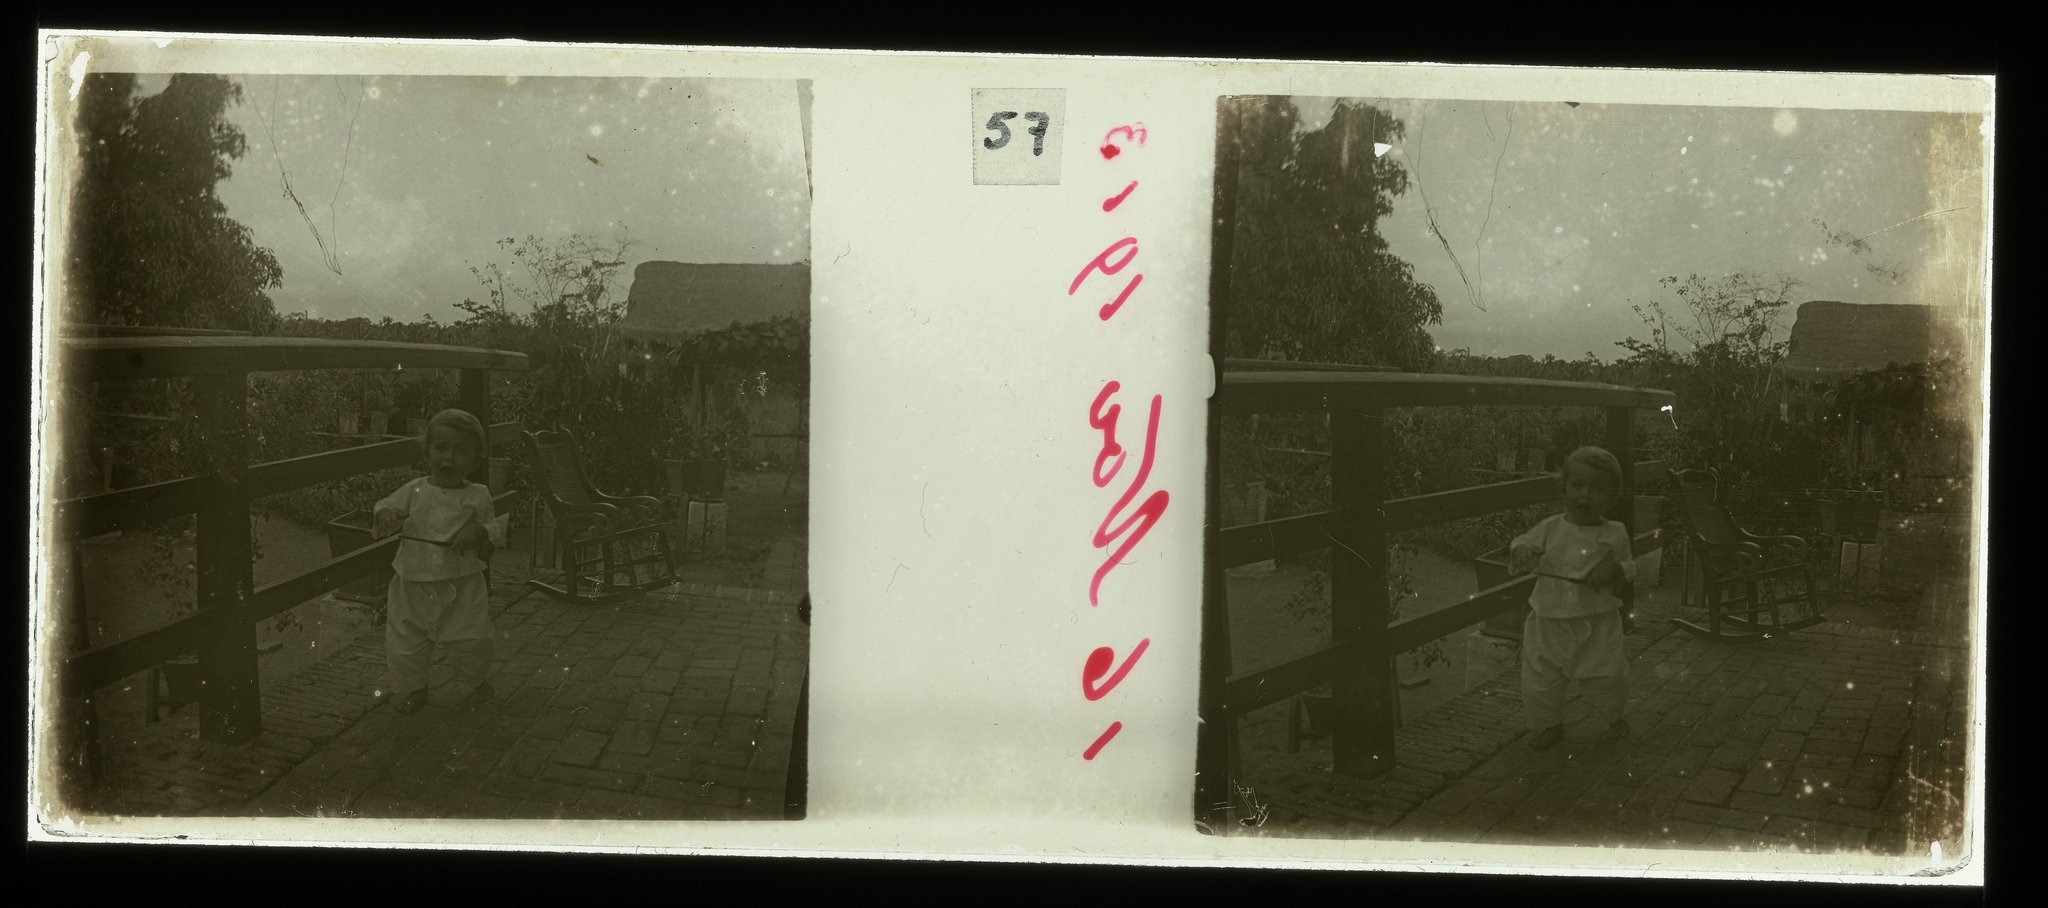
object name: stereograph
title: Gerard Brouwers op Plantage Accaribo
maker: theodoor brouwers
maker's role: amateurfotograaf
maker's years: 1874-1932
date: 1913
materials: glass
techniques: photography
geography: suriname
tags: amsterdam, theodoor brouwers, plantation, suriname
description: In de periode 1911-1932 woonde op plantage Accaribo in Suriname de familie Brouwers van wie de foto's afkomstig zijn. Rond 1910 vond Theodoor Brouwers werk op plantage Accaribo. In 1929 werd hij eigenaar van de plantage. Op Accaribo werden in zijn tijd bananen geproduceerd en wat koffie.